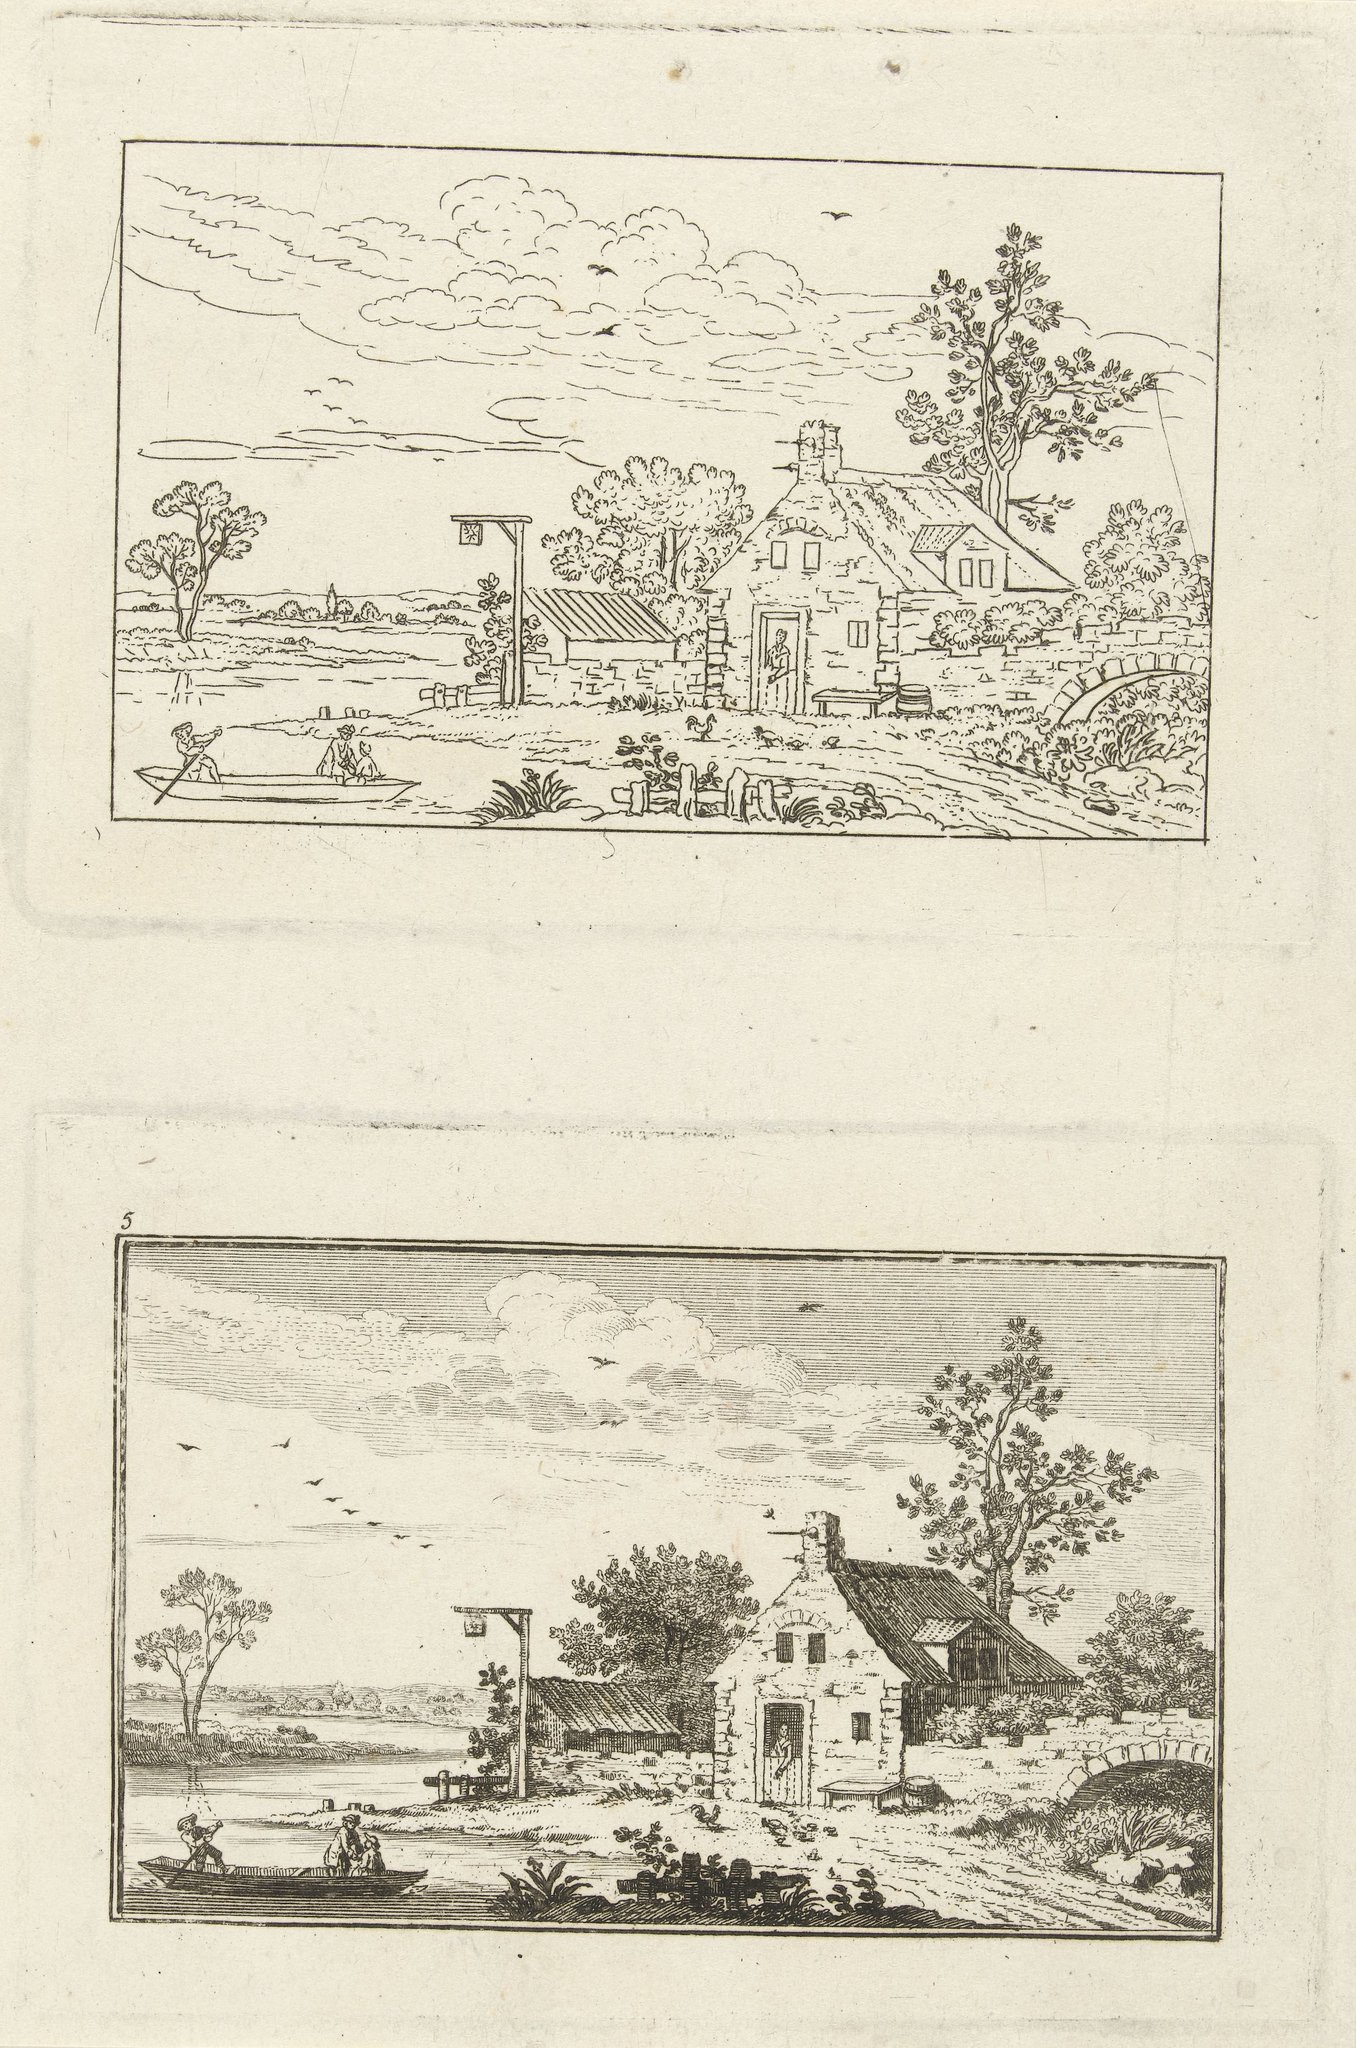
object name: print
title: Landschappen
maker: christian friedrich fritzsch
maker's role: print maker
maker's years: 1719-1774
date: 1729-1774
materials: paper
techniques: etching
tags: landscapes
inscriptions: collector's mark: Lugt 2228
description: Twee dezelfde landschappen boven elkaar met rechts een huis en links een rivier waarop een roeiboot vaart. Het bovenste landschap betreft een nog uit te werken prent, het onderste landschap is afgemaakt. Gedrukt van twee platen, de onderste prent is linksboven met een 5 genummerd.